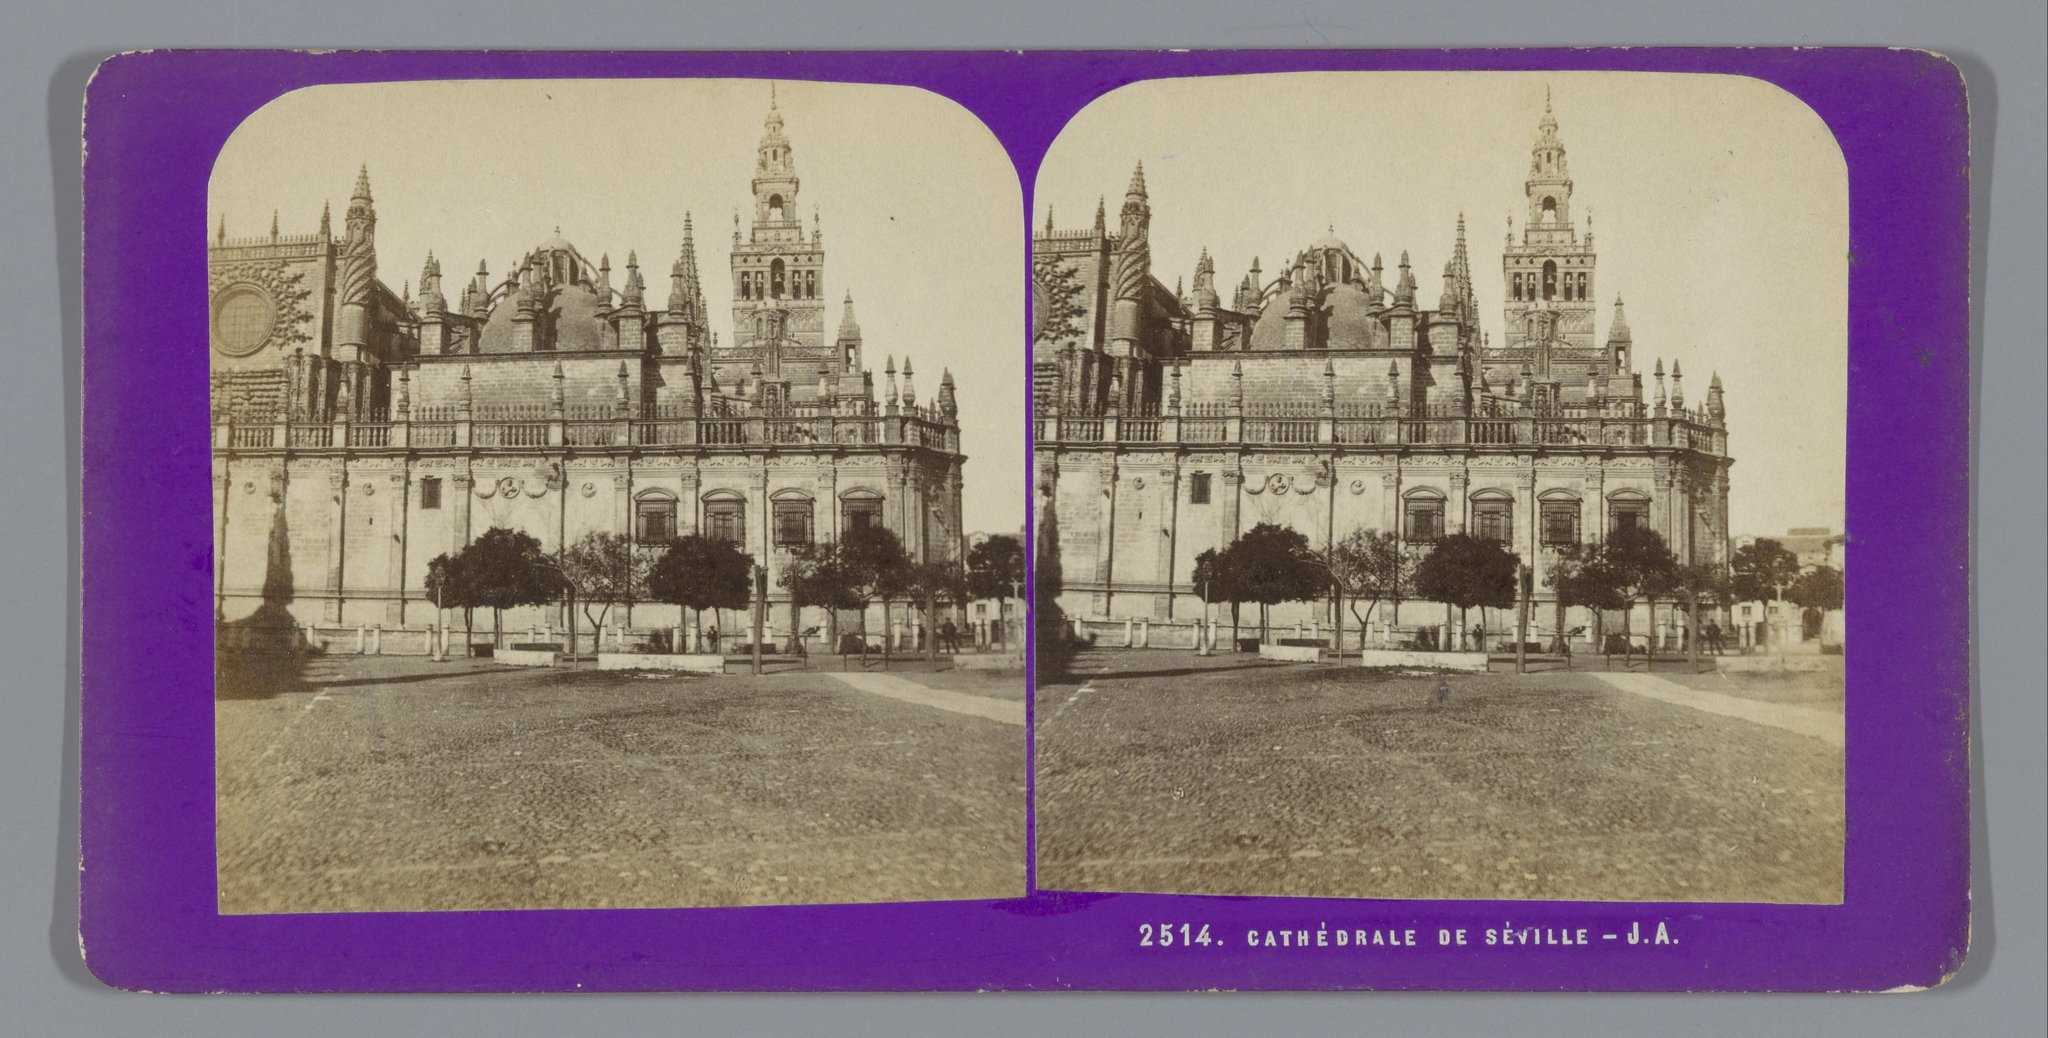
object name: stereograph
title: Exterieur van de Kathedraal van Sevilla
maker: jean andrieu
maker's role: fotograaf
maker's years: 1816-1872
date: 1862-1876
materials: cardboard, photographic support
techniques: albumen print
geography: sevilla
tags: church (exterior), façade (of house or building)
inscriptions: number: ‘2514.’